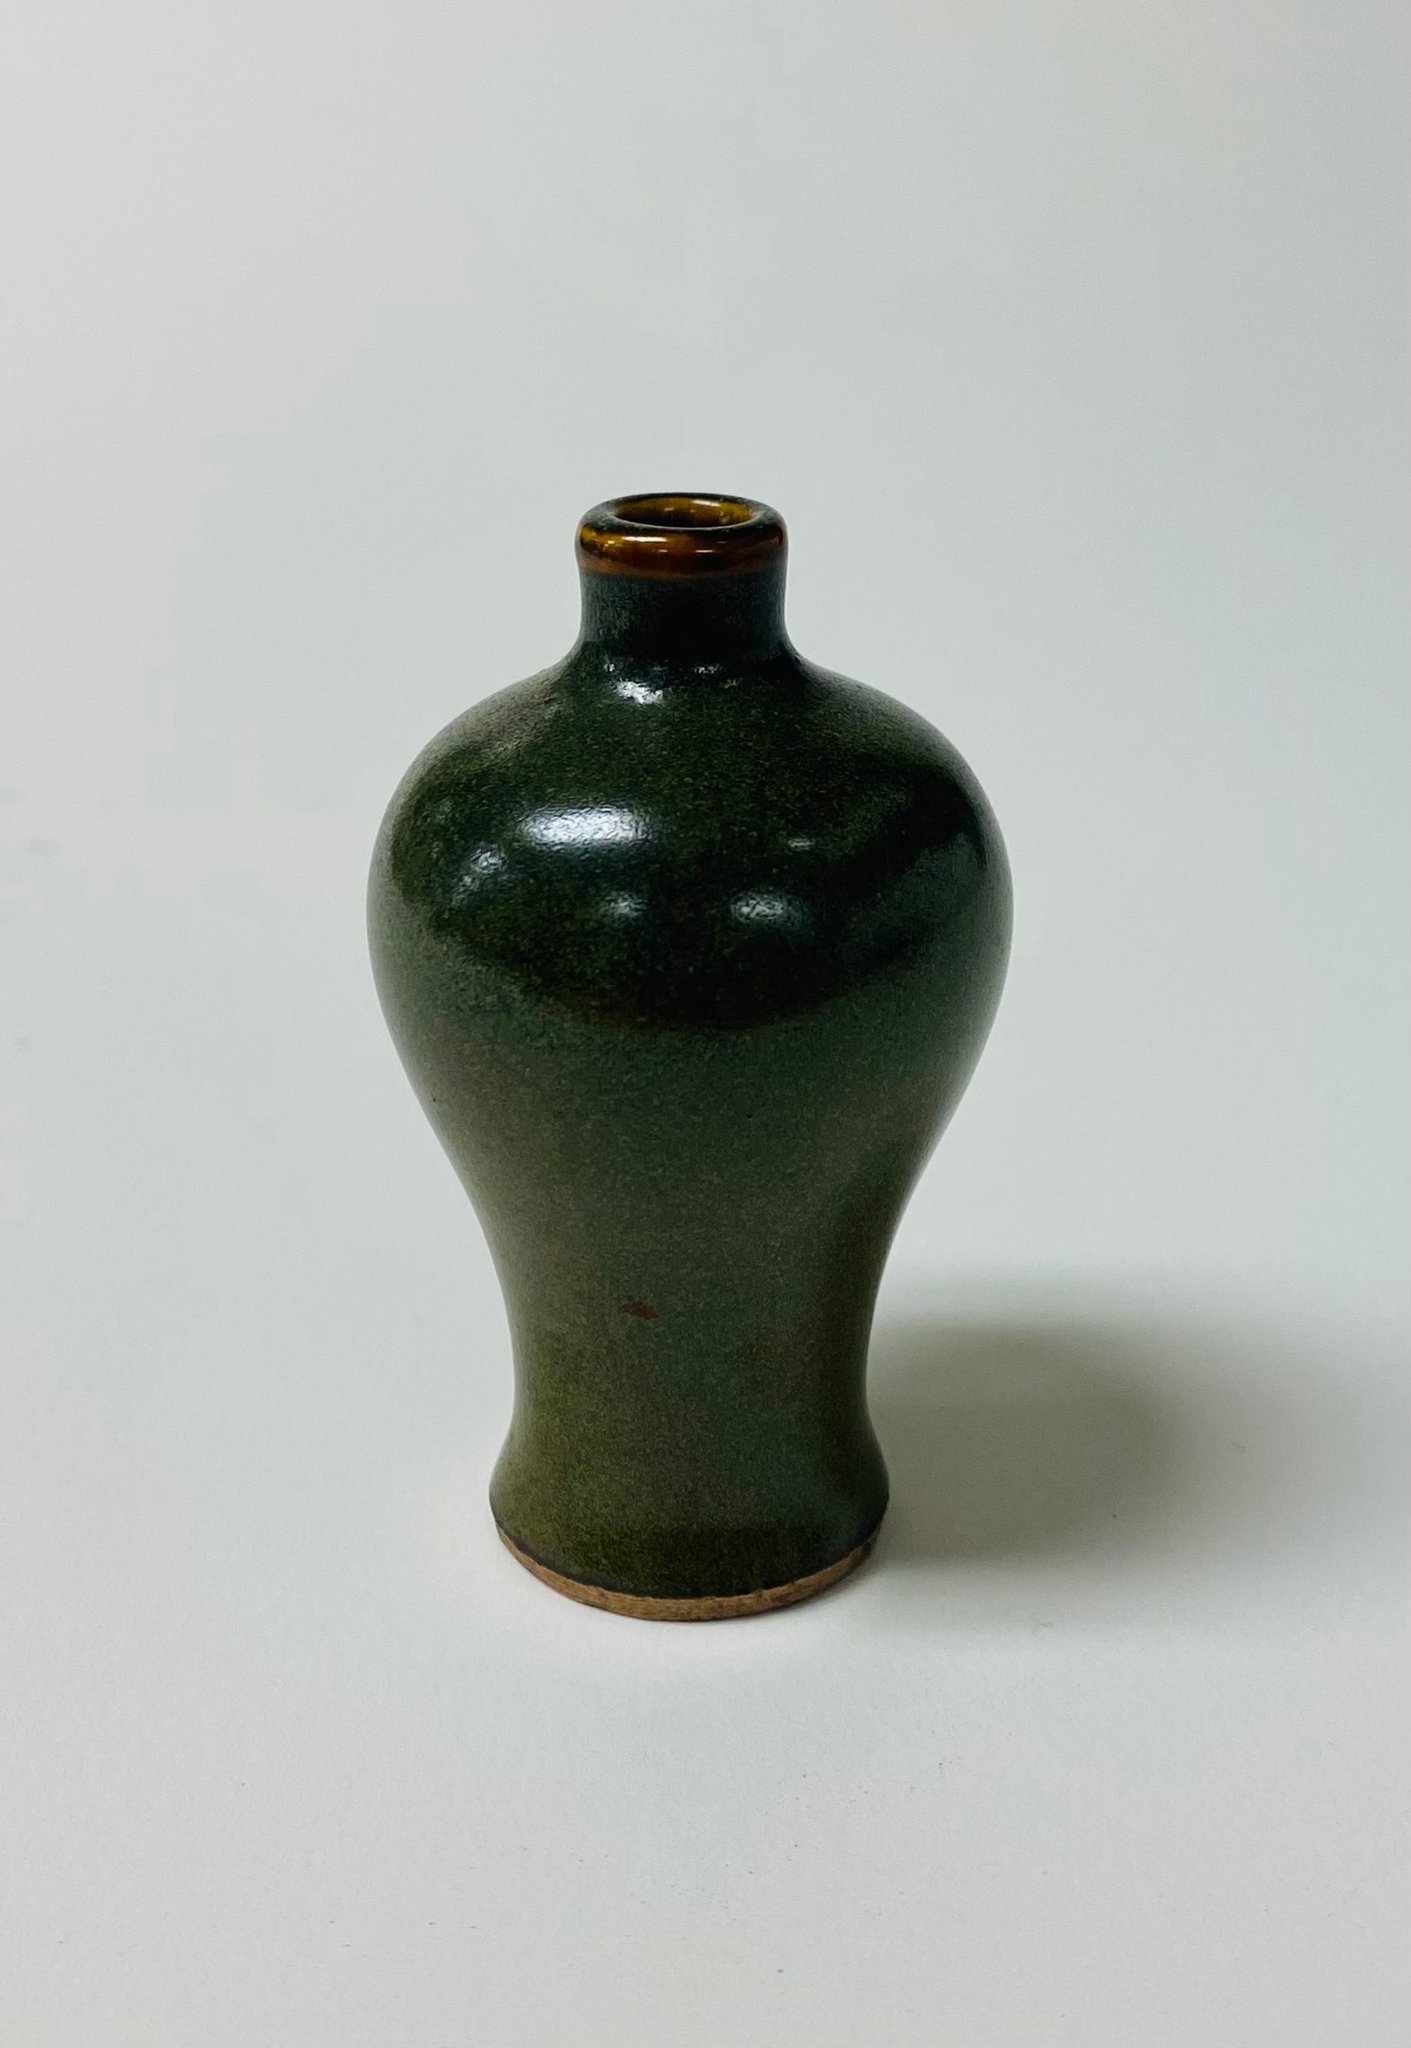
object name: vase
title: Miniature meiping vase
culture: chinese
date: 1701-1800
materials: glaze, porcelain